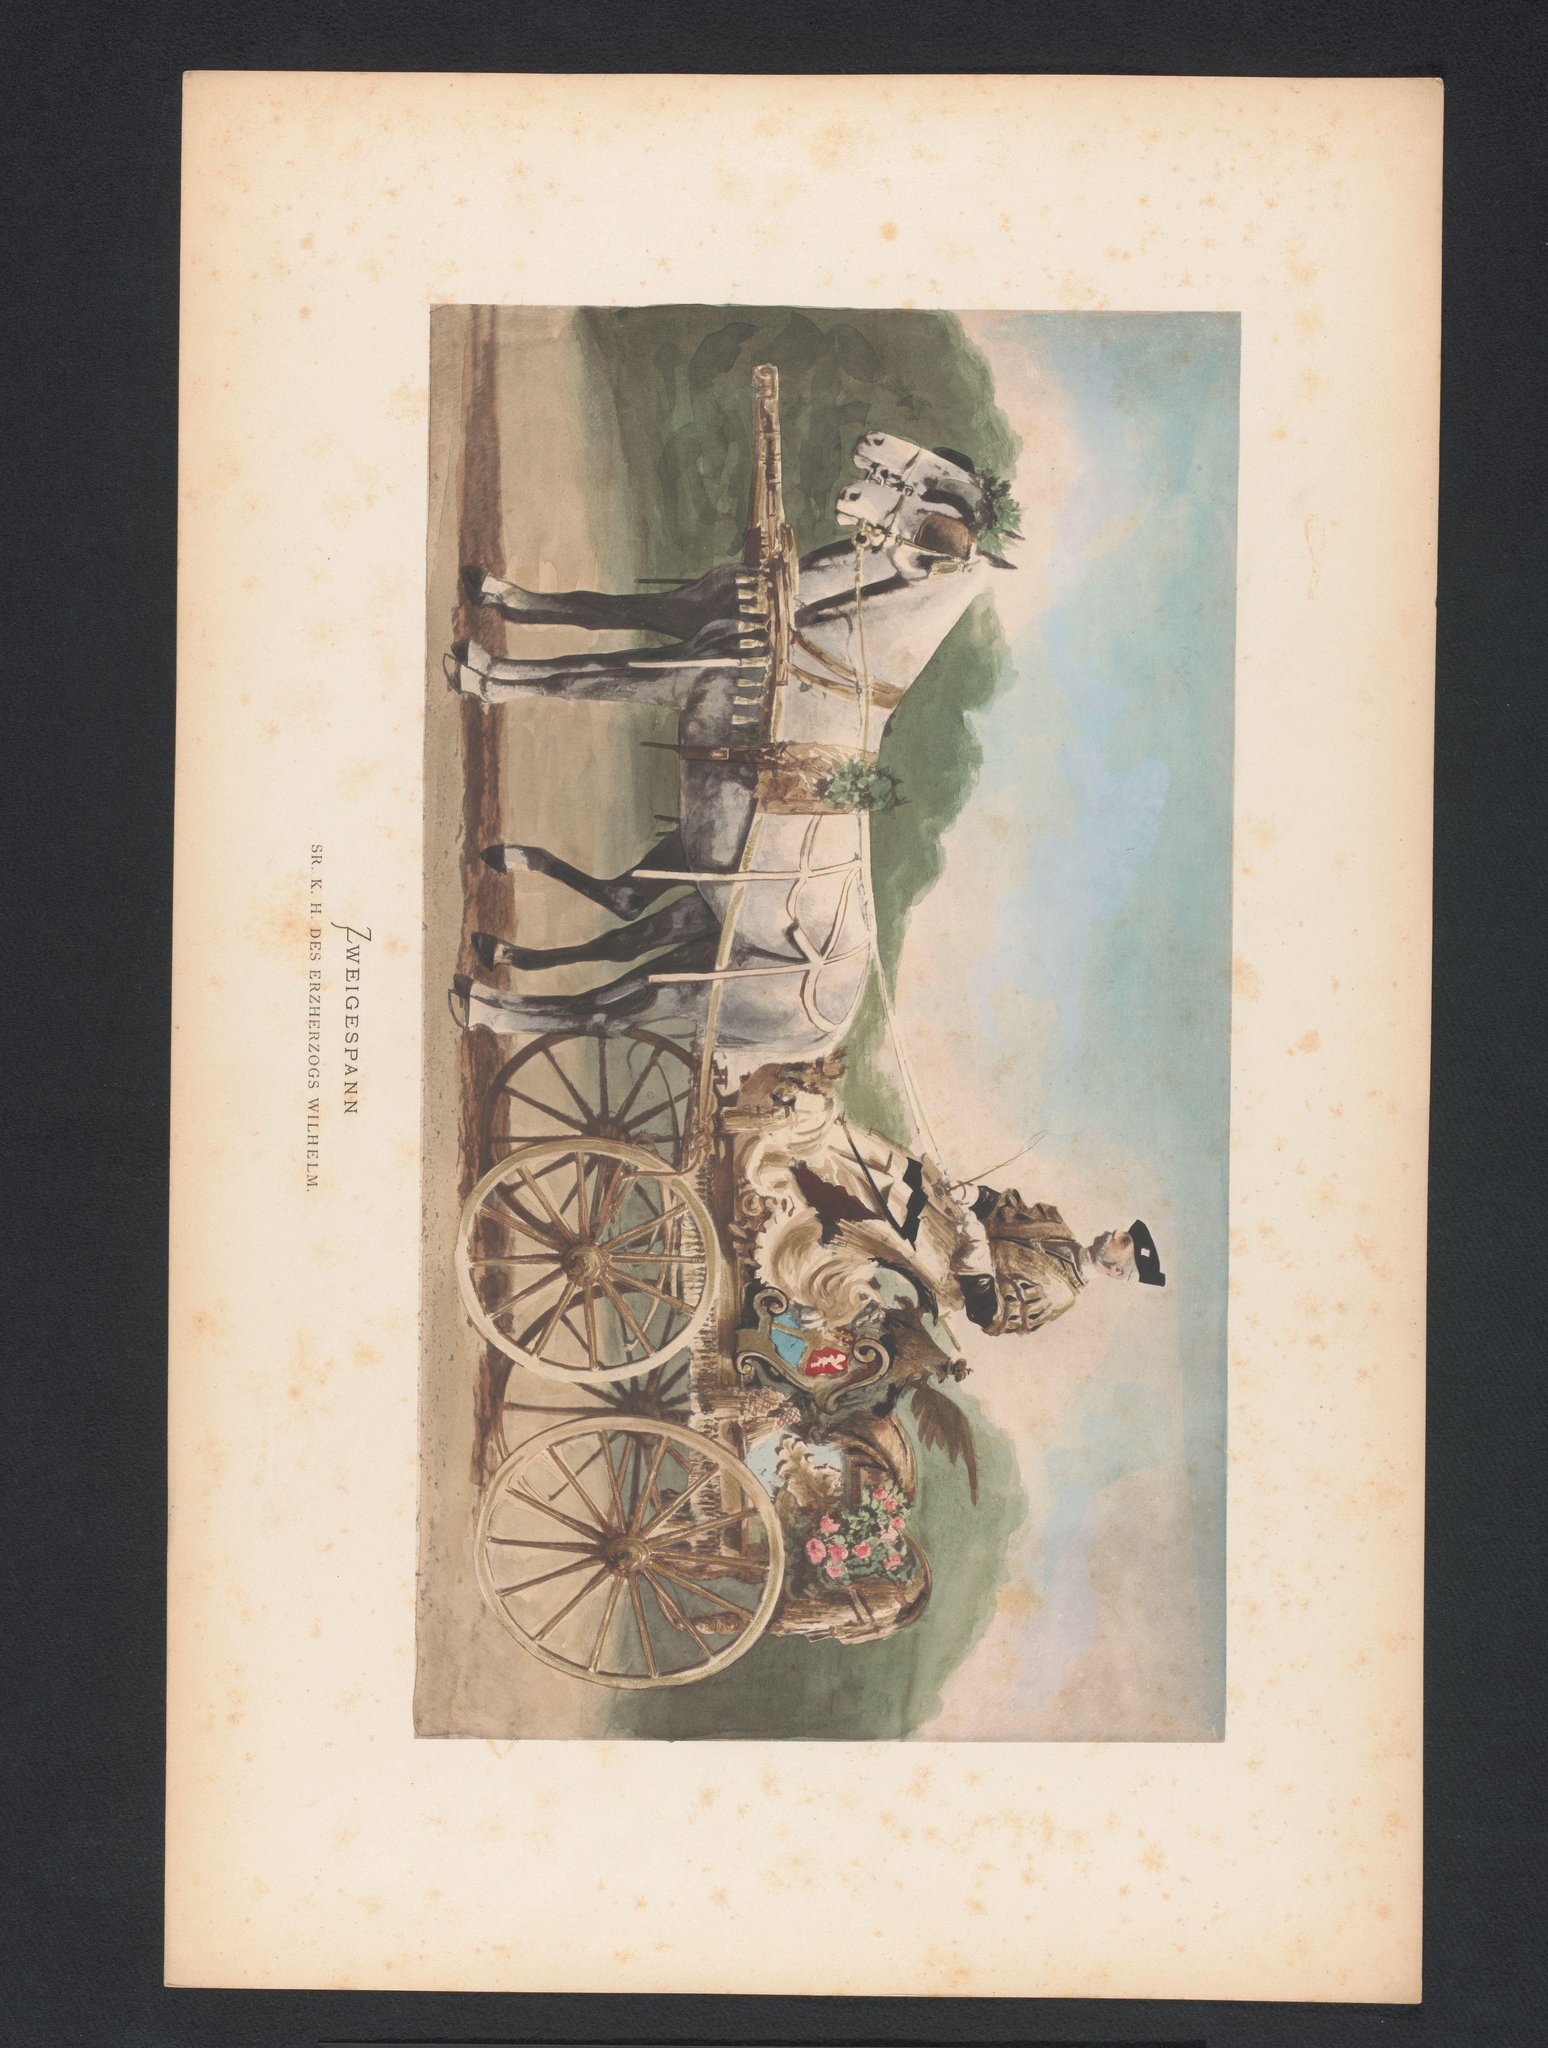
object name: photomechanical print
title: Koets met twee paarden, van Willem van Oostenrijk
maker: Anonymous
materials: paper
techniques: photograph, hand coloring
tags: four-wheeled vehicle drawn by two animals (+ one person ~ traffic and transport)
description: Deze prent maakt deel uit van een omslag met 86 prenten op 78 bladen en 11 tekstbladen.